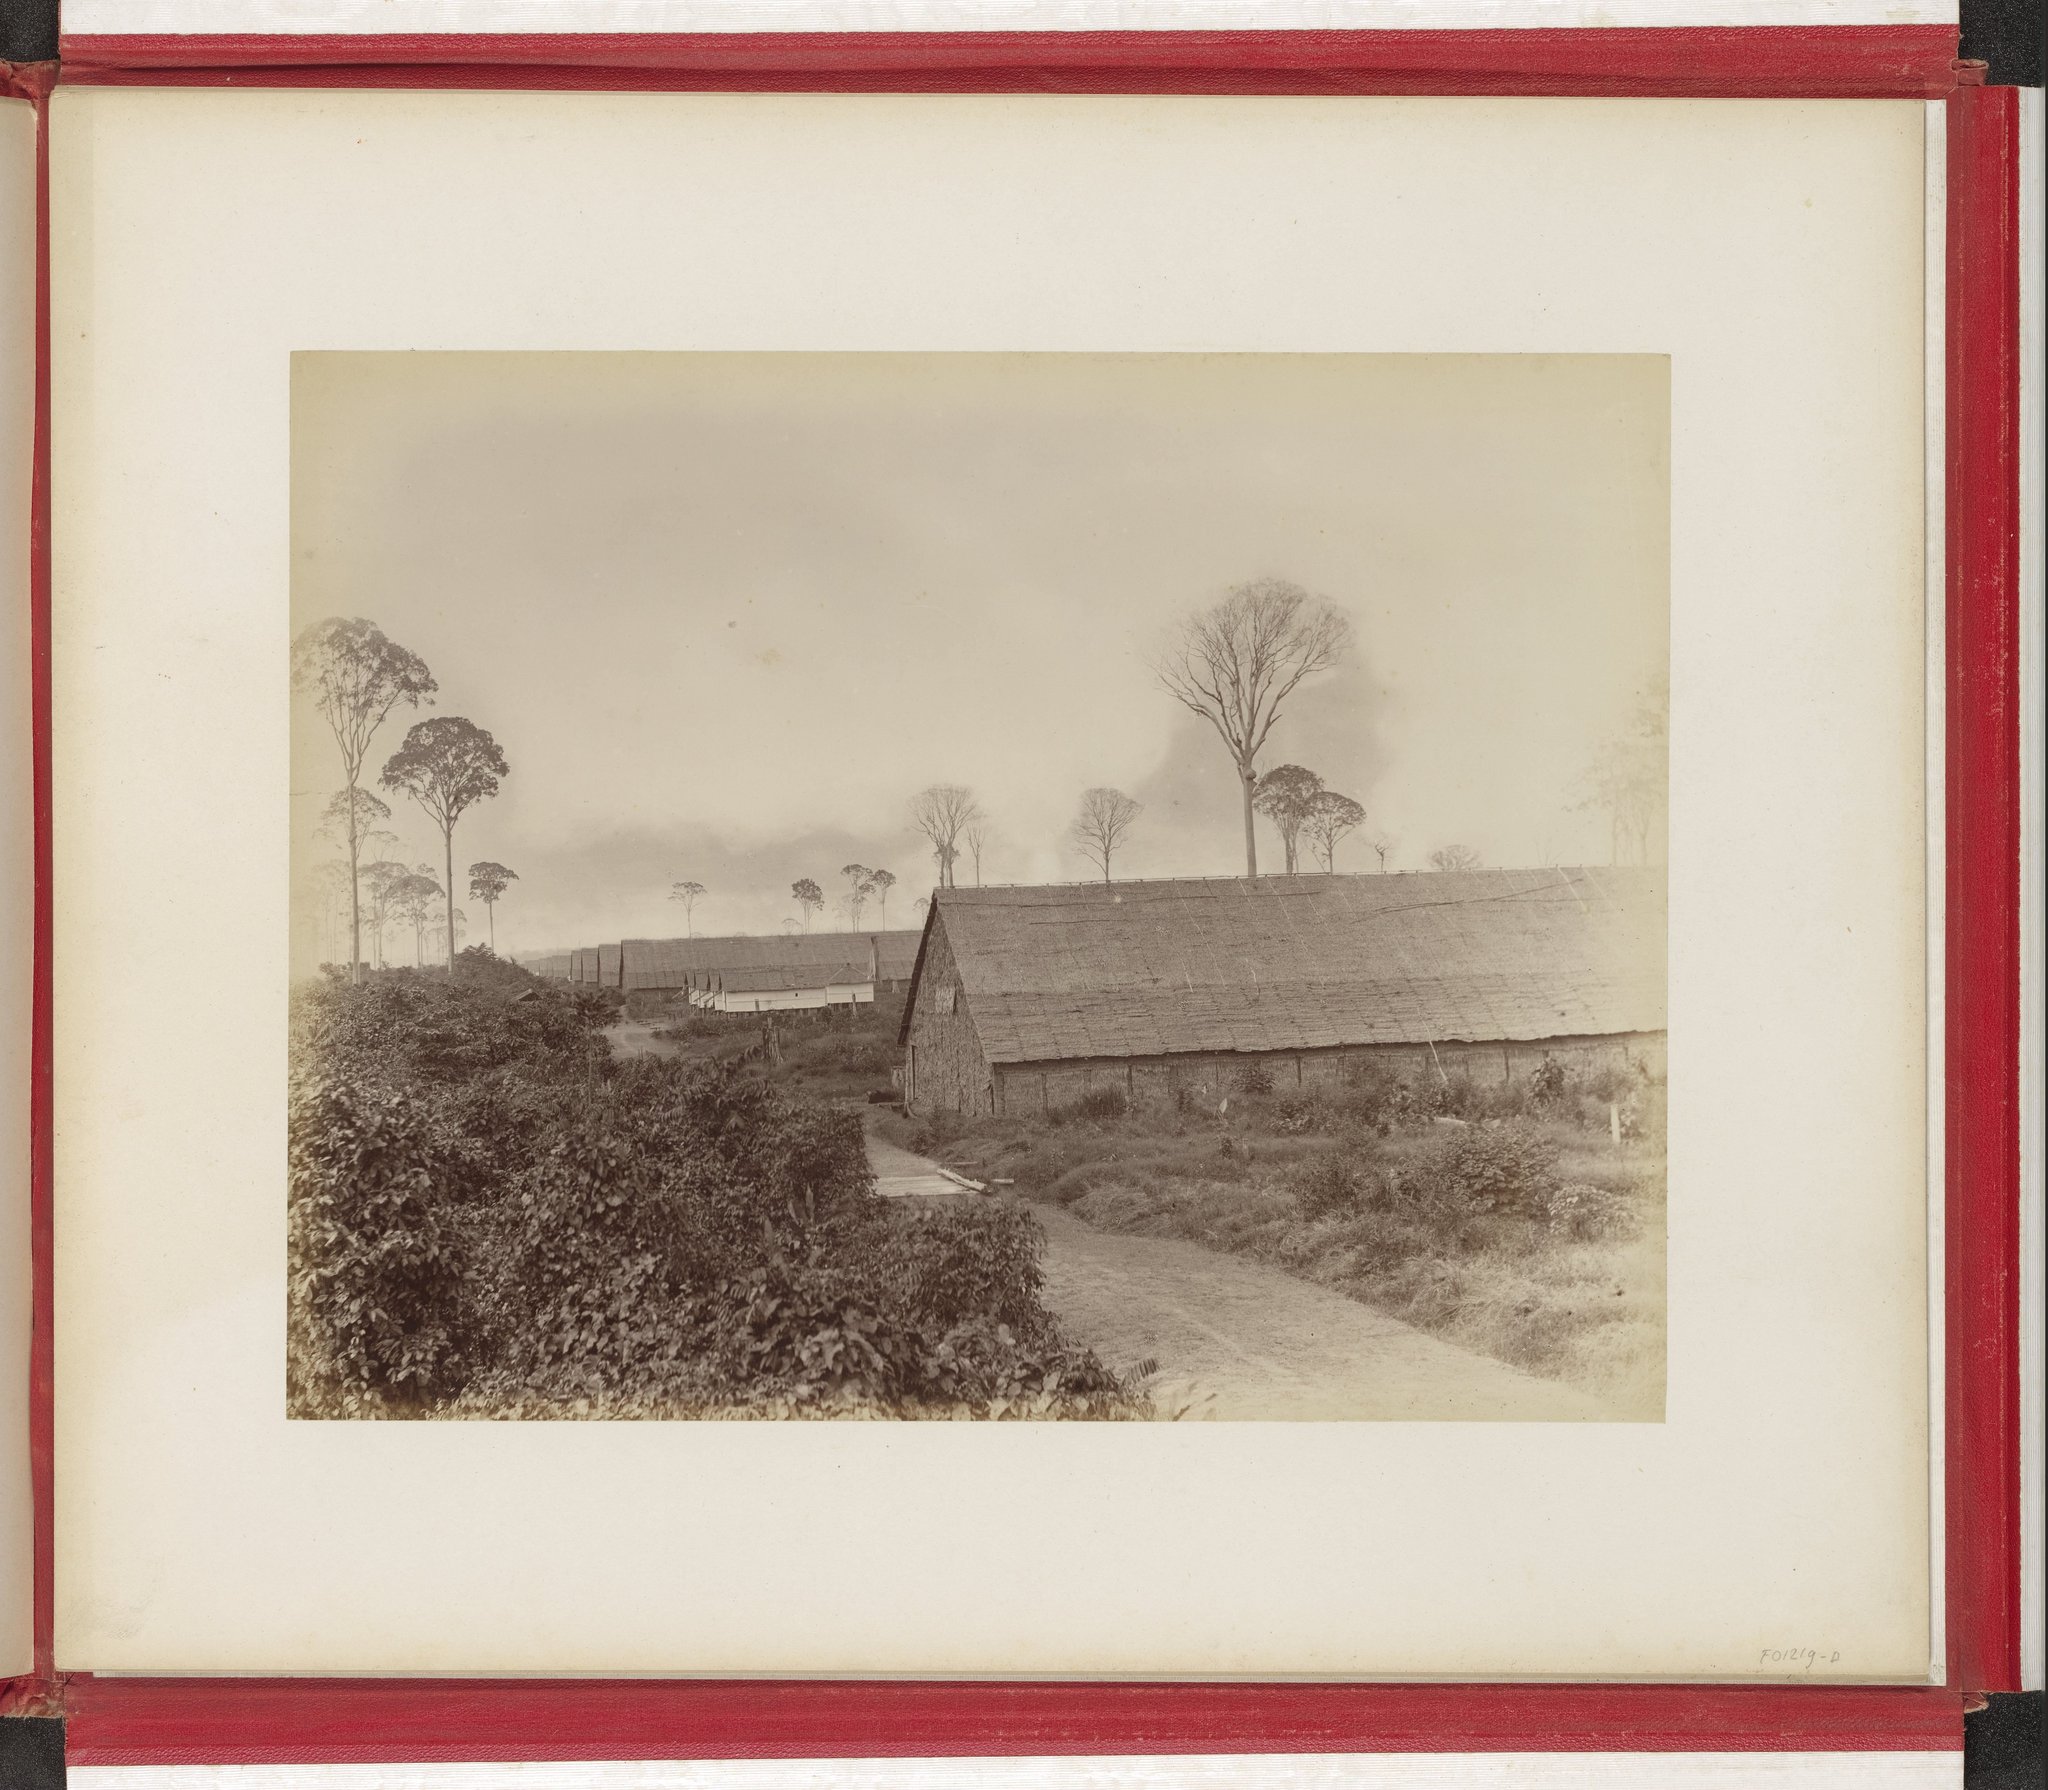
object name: photograph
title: Aanleg van een tabaksplantage op Sumatra, 4e stadium: bouw van loodsen en bijgebouwen voltooid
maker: Anonymous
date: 1880-1890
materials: cardboard, photographic support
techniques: albumen print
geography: east sumatra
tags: large-scale structure for storage, e.g.: warehouse, depot, silo, plantation, tobacco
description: Onderdeel van Fotoalbum van de aanleg van een tabaksveld op de oostkust van Sumatra.